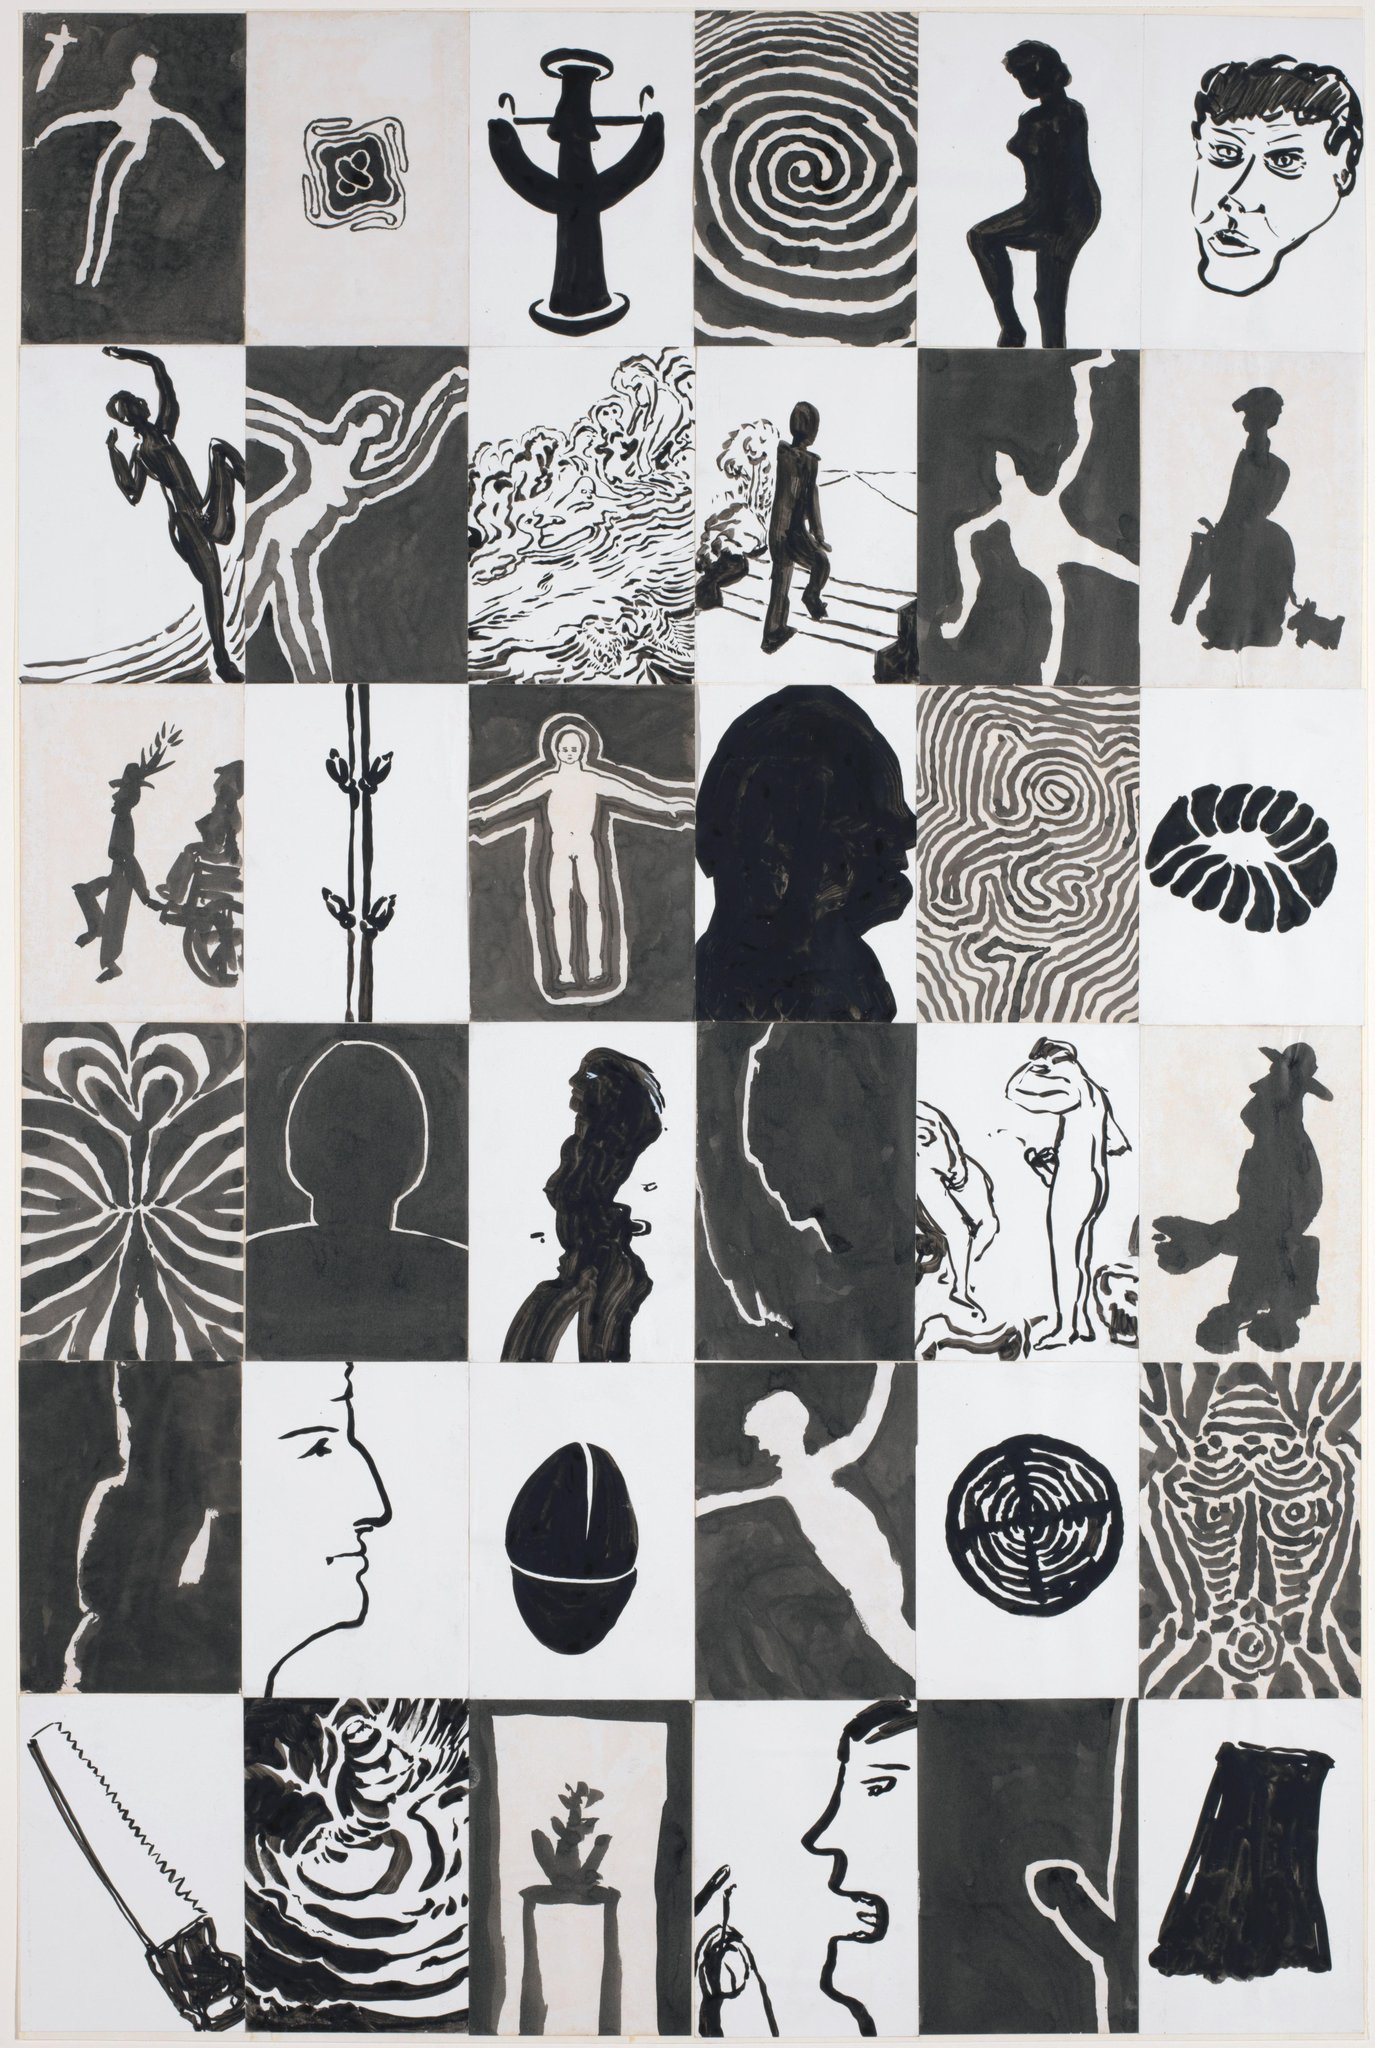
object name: drawing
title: 36 voorstellingen, waaronder zaag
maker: pieter holstein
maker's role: draughtsman, painter, print maker, sculptor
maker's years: 1934-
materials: ink, paper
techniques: brush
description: 36 voorstellingen binnen vierkanten, waaronder een zaag, eikel en penis.